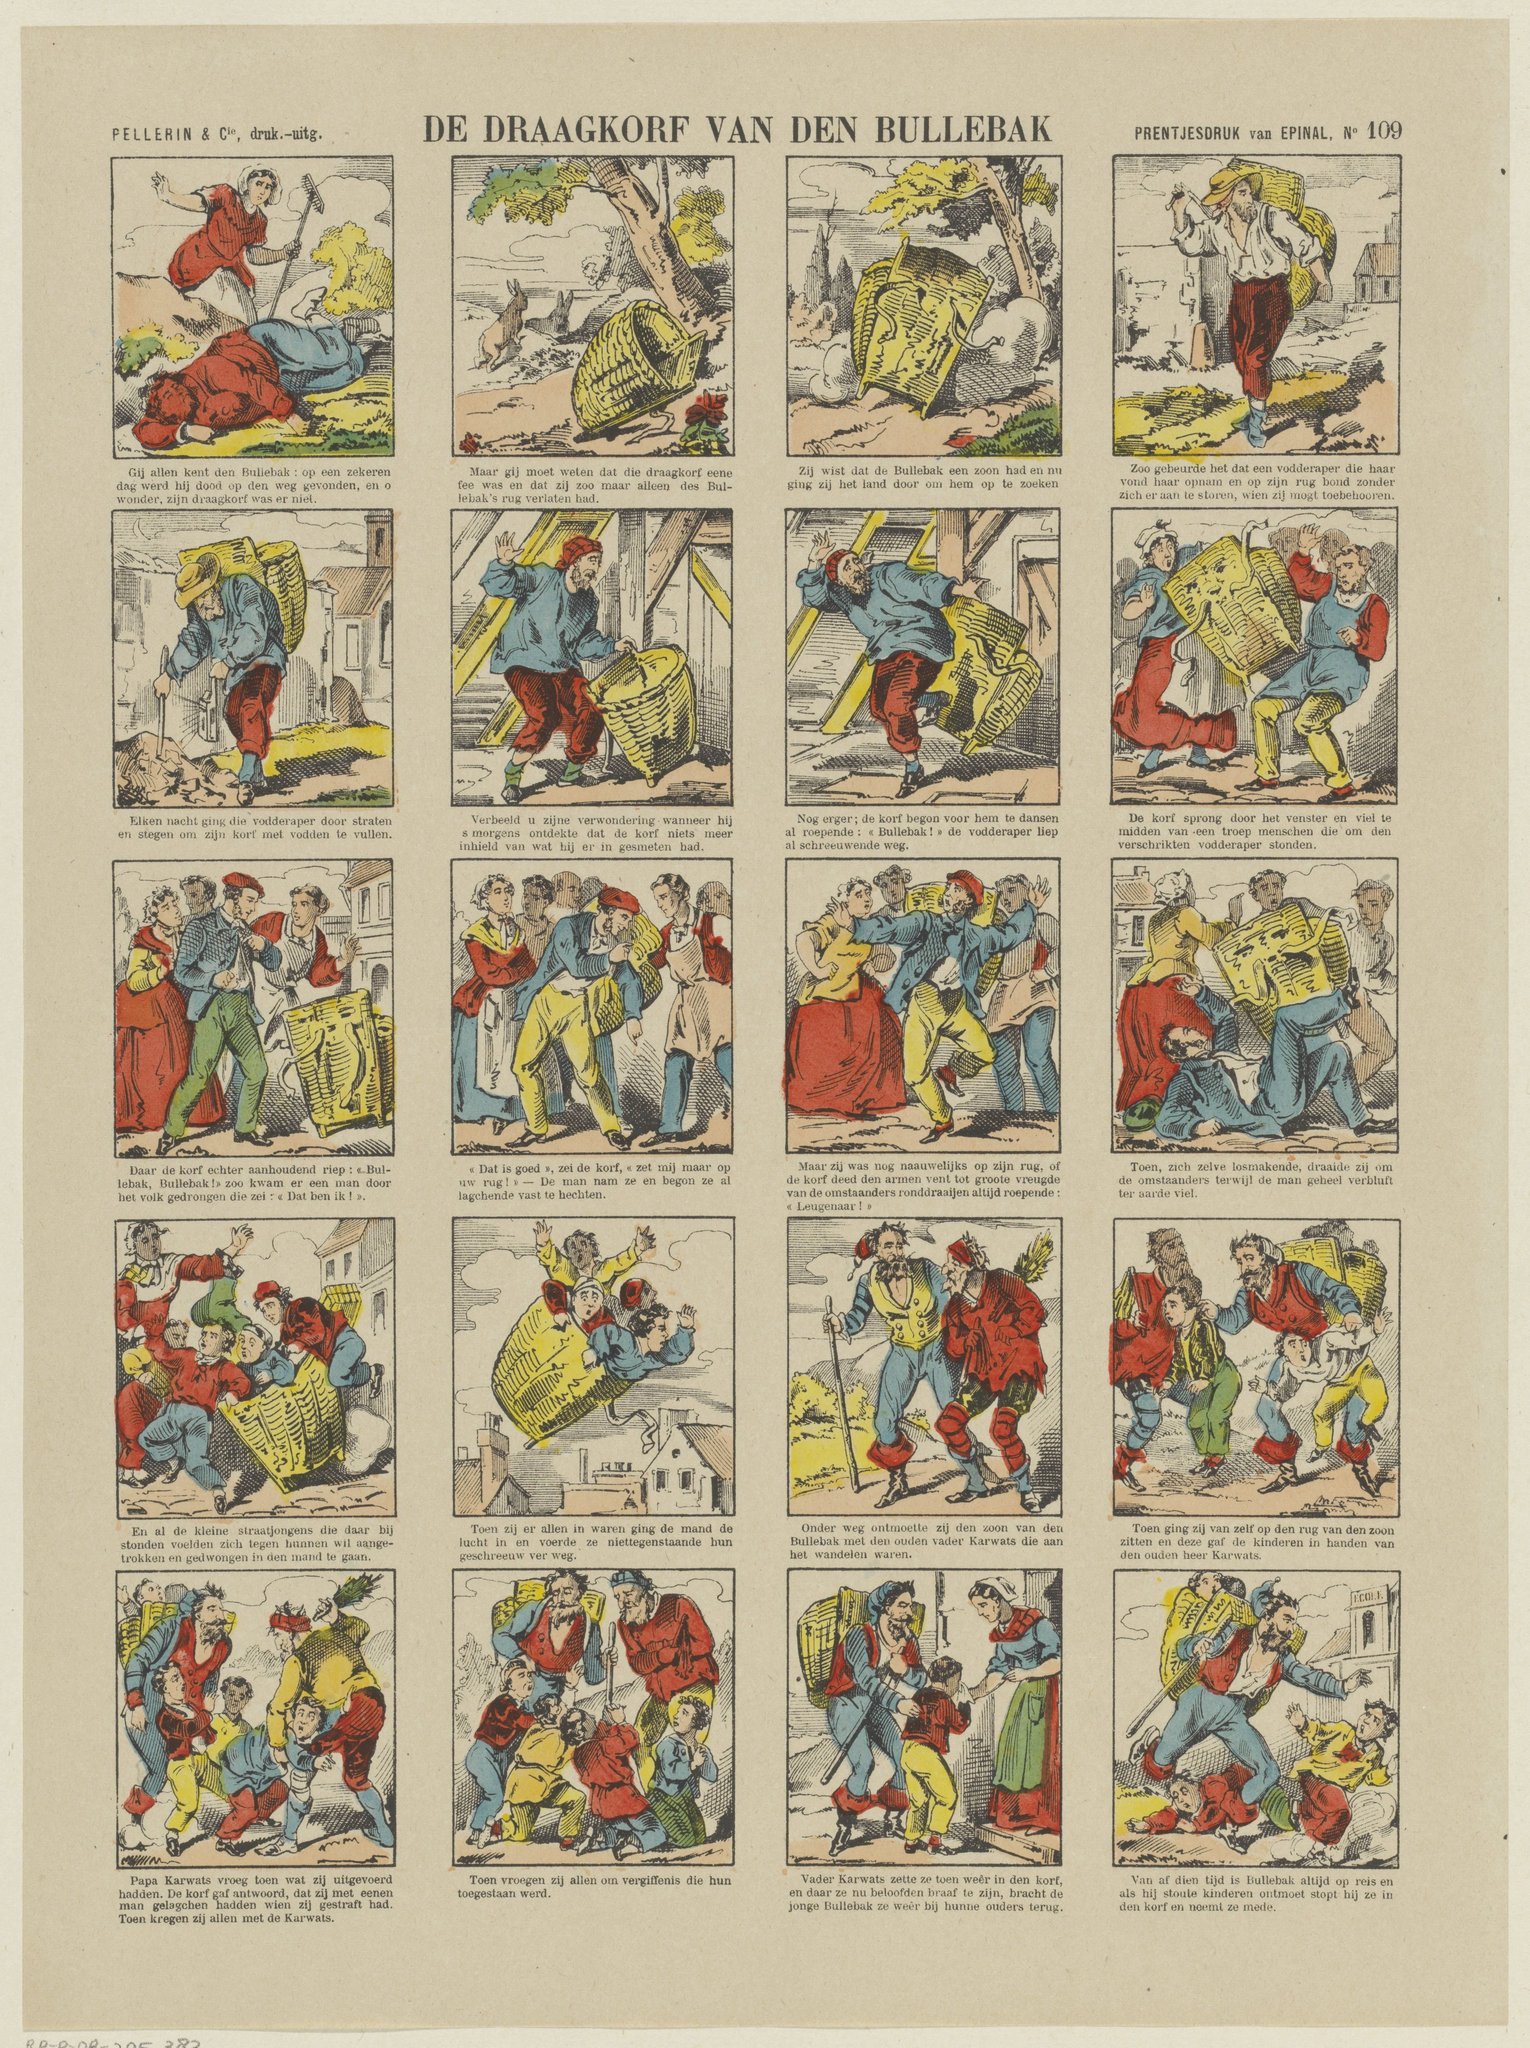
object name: popular print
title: De draagkorf van den bullebak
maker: Anonymous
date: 1902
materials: paper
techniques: colour, letterpress printing, lithograph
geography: epinal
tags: correction of naughty children, magic, supernaturalism, occultism, bad behaviour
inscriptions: collector's mark: Lugt 2760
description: Blad met 20 voorstellingen over de magische draagkorf van Bullebak. Onder elke afbeelding een onderschrift. Genummerd rechtsboven: No 109.